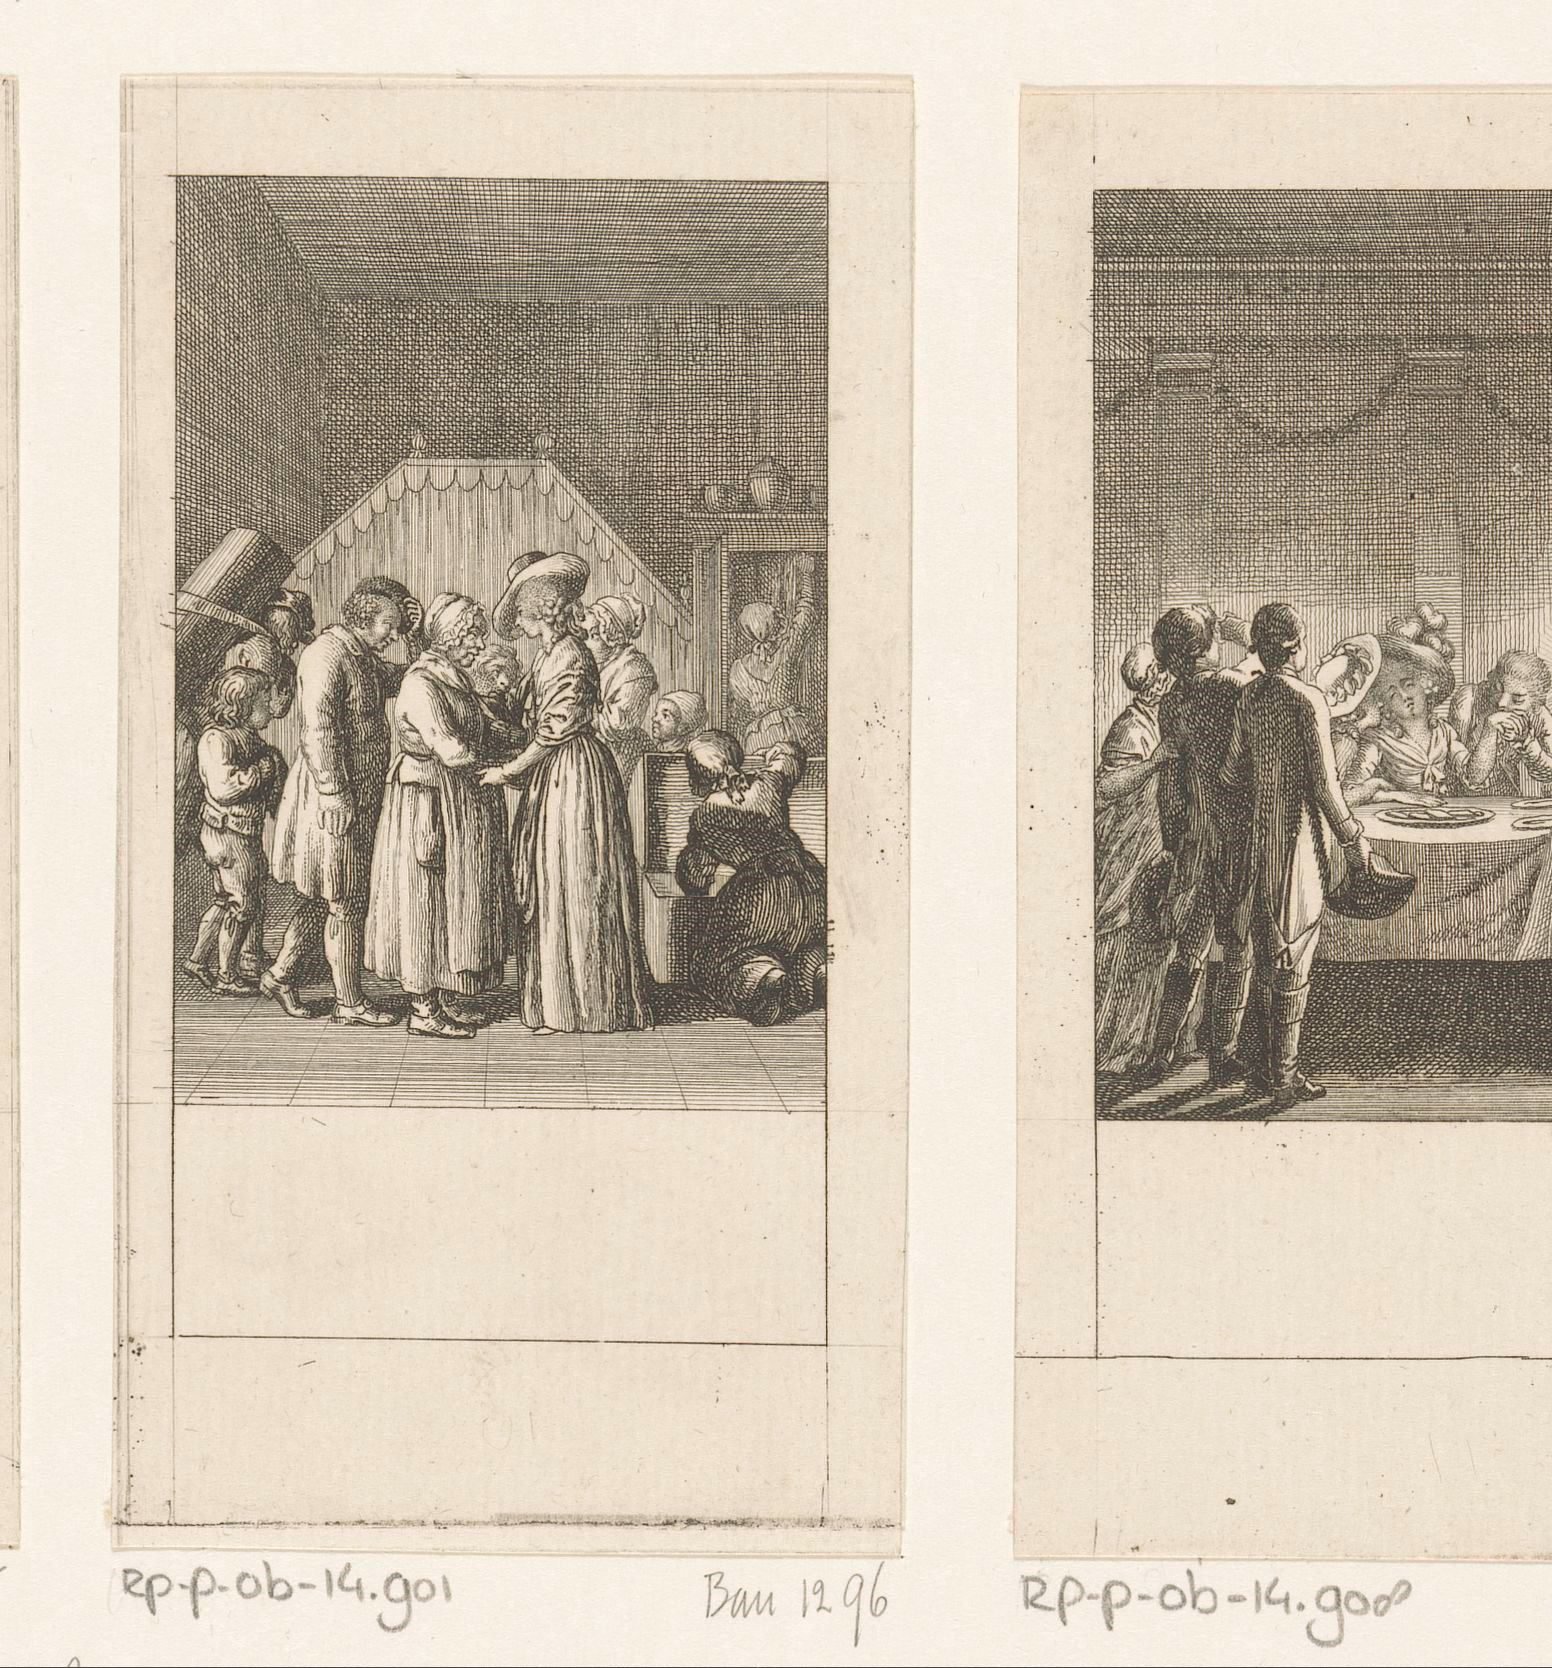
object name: print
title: Camille wordt joviaal door de dorpsbewoners ontvangen aangezien dezen haar waarderen om de goedheid van haar hart en niet haar rijkdom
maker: daniel nikolaus chodowiecki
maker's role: draughtsman, print maker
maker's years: 1726-1801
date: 1787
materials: paper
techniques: etching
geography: berlin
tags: moving (house), shaking hands, 'dextrarum junctio', literature, interior of the house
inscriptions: collector's mark: Lugt 2228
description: Vervaardigd voor J. F. Jünger's vertaling van 'Camille: oder, Briefe zweyer Mädchen aus unserm Zeitalter'. Een latere staat gebruikt in: Genealogischer Taschenkalender. Auf das Jahr 1788. Berlijn: Königl. Academie der Wissenschaften, 1787.